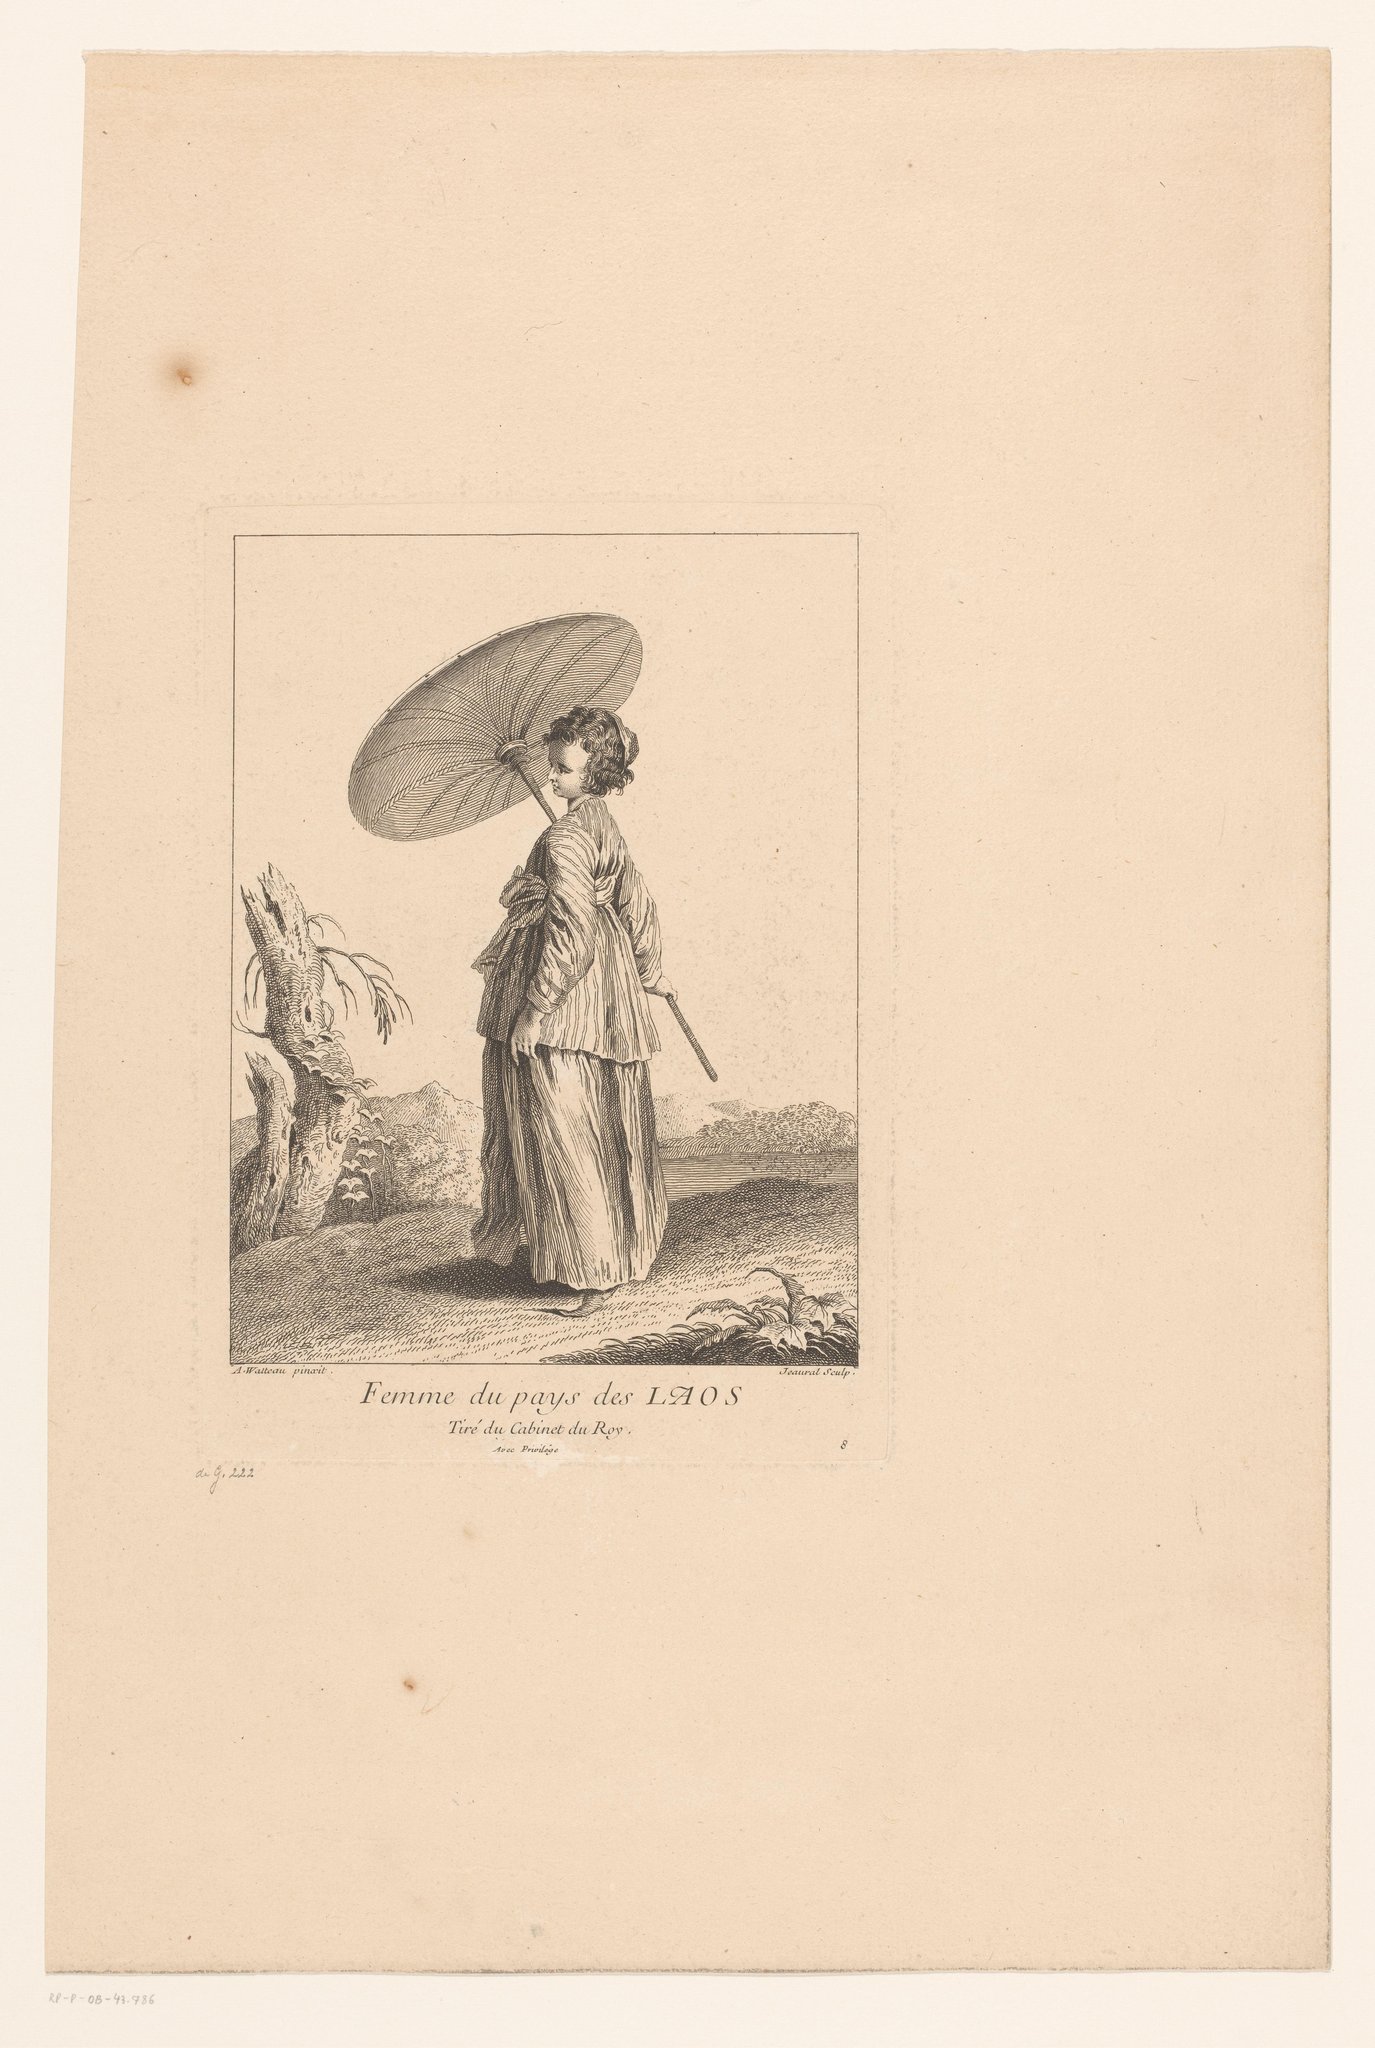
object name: print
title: Prenten naar Antoine Watteau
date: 1731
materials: paper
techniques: engraving, etching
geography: france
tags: chinese (+ costume), landscapes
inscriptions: collector's mark: Lugt 2228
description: Plaat 257 uit 'L'Oeuvre d'Antoine Watteau', een serie van 271 platen, inclusief twee titelprenten, naar schilderijen door Watteau en verzameld door Jean de Jullienne. Maakt ook deel uit van een serie van 30 prenten over Chinese kostuums en van een subserie van 12 prenten gemaakt door Jeaurat.